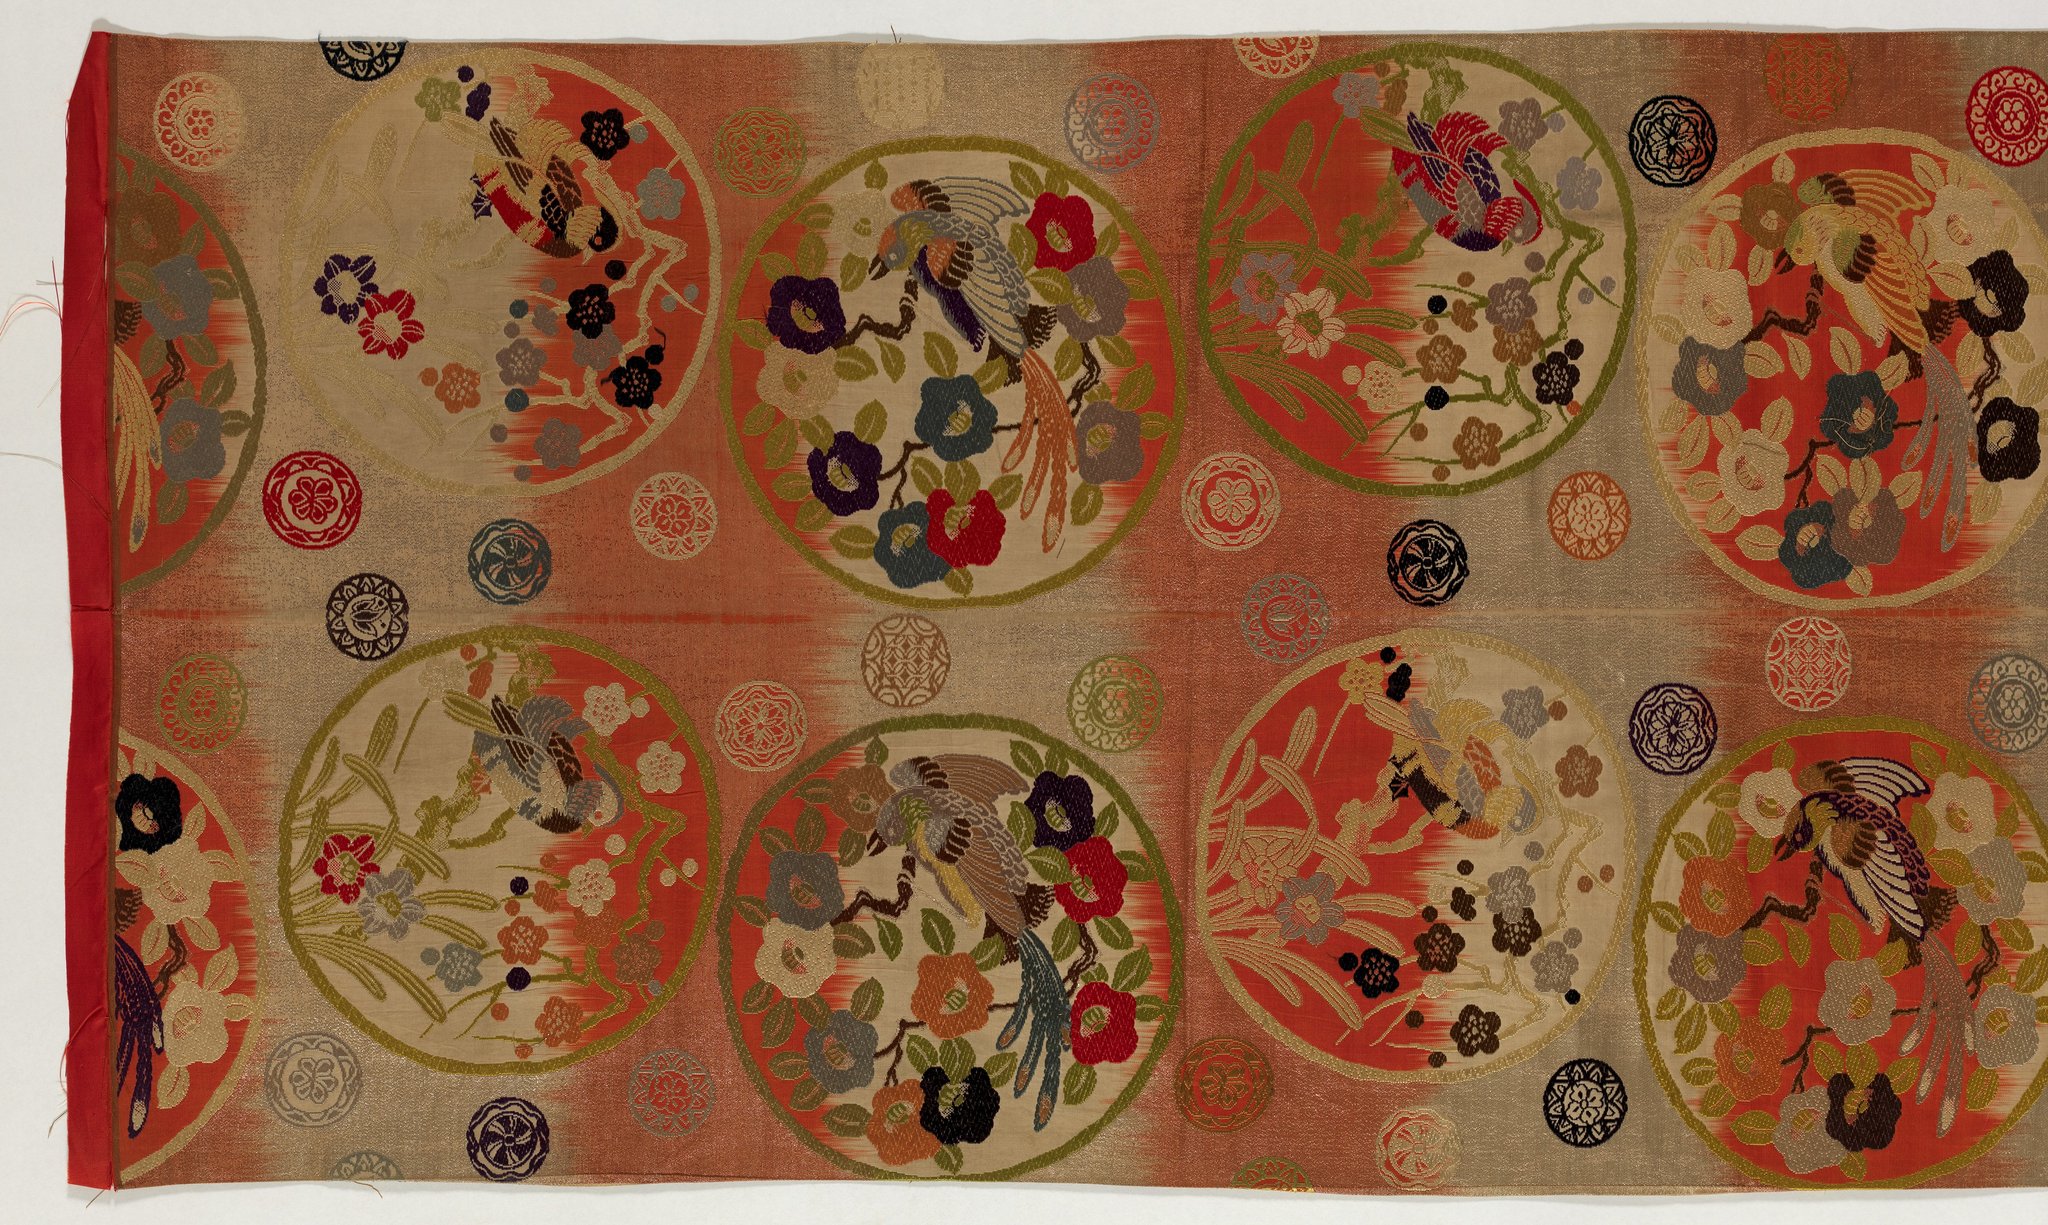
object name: obi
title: Obi with Repeating Floral Roundels and Birds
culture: japanese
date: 1867-1933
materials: metal thread, silk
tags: birds,flowers